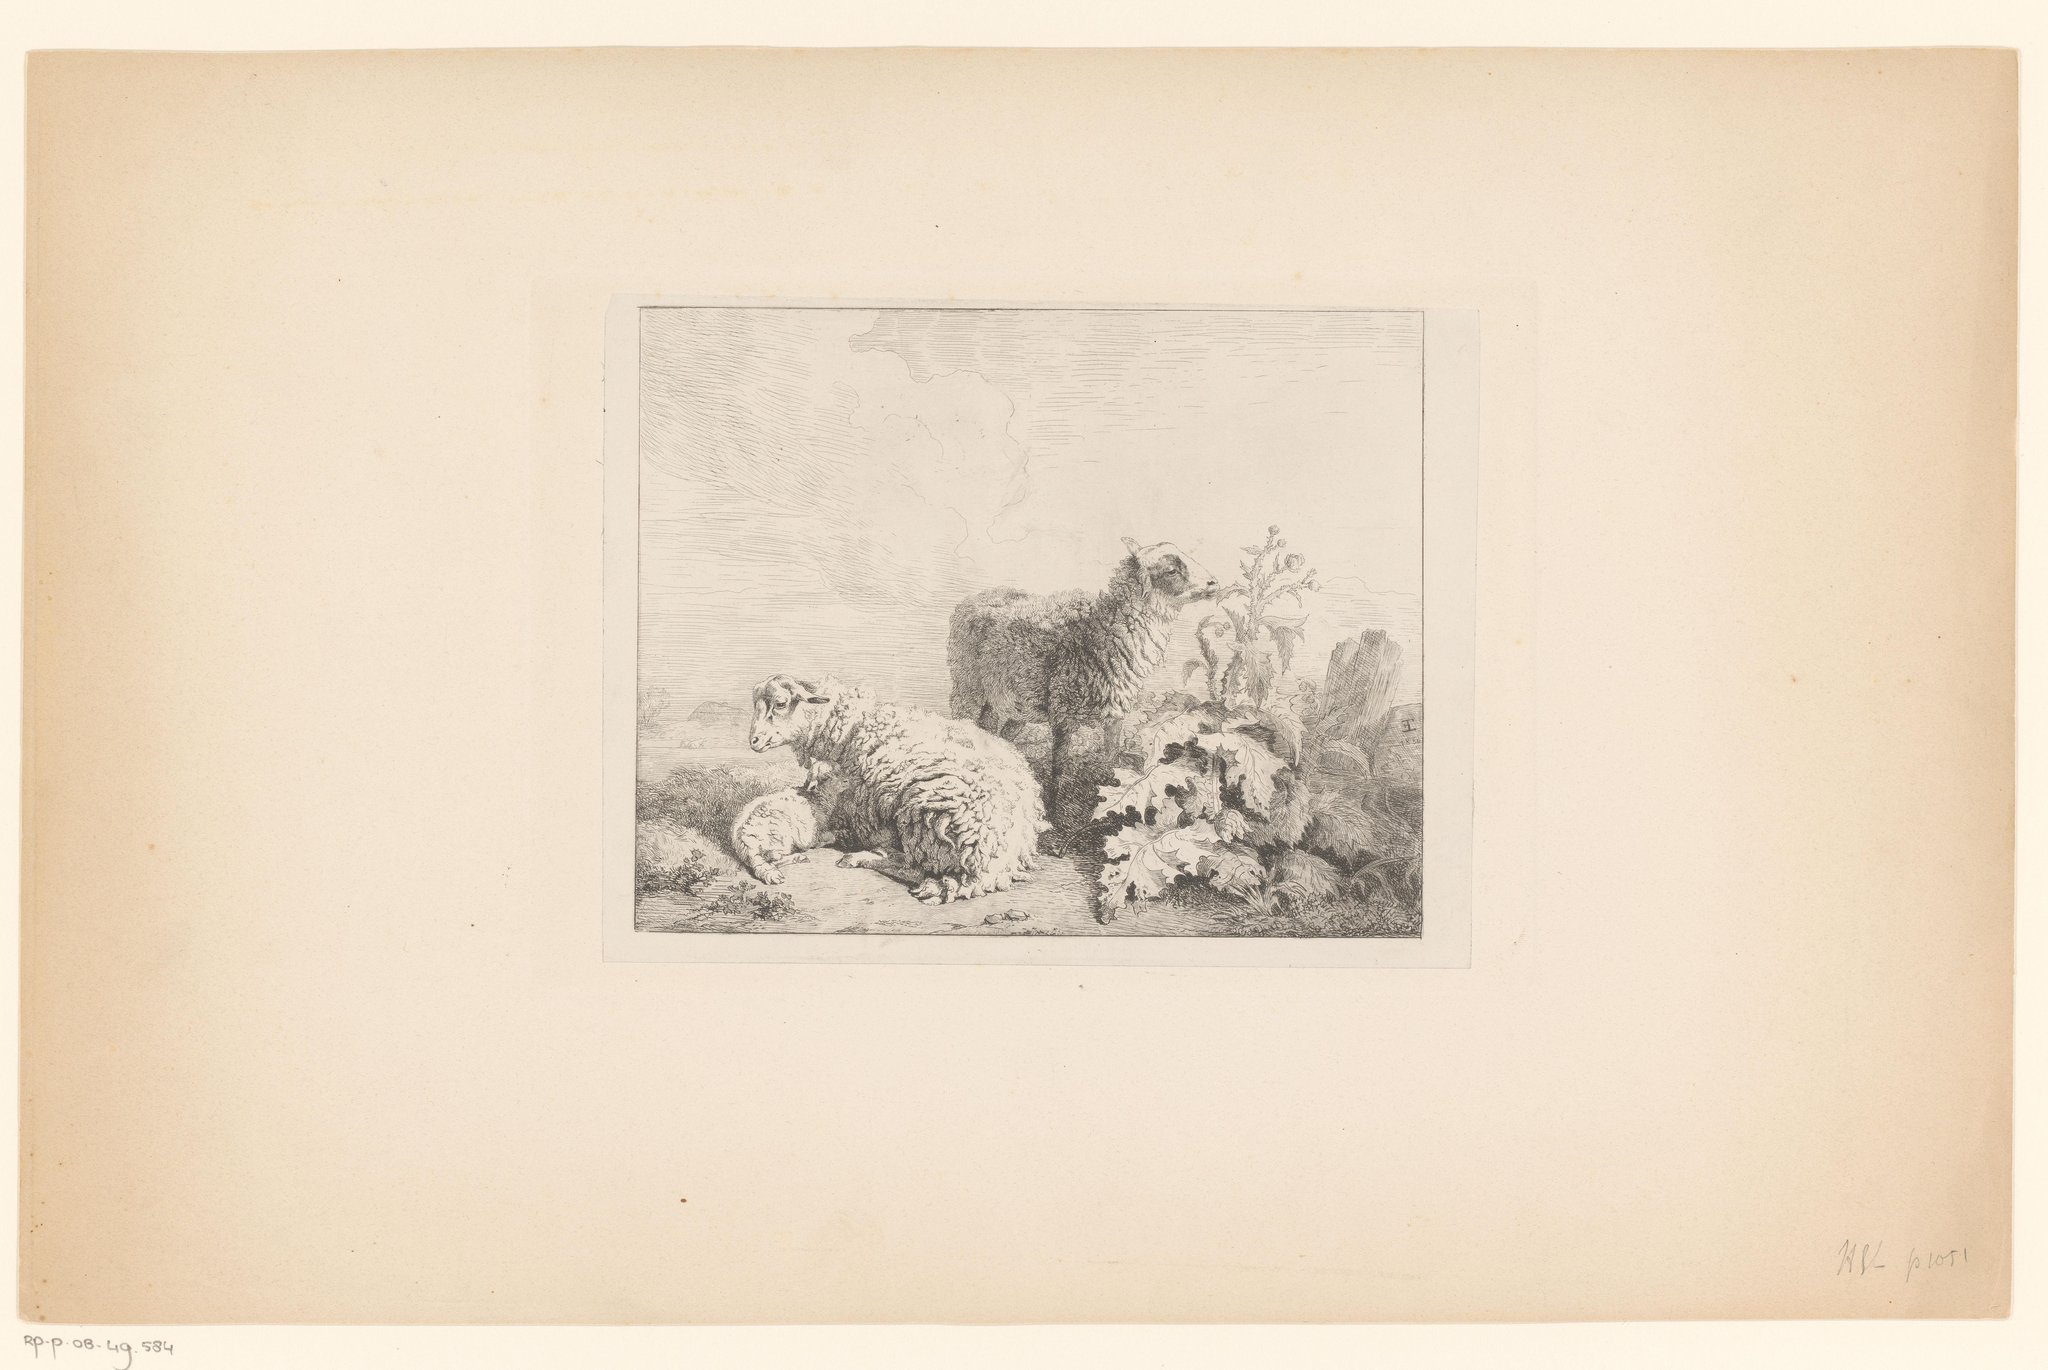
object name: print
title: Twee schapen en een lam in een landschap met distel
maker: edmond tschaggeny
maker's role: print maker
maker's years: 1818-1873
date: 1850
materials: paper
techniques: etching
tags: sheep, plants and herbs: thistle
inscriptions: date